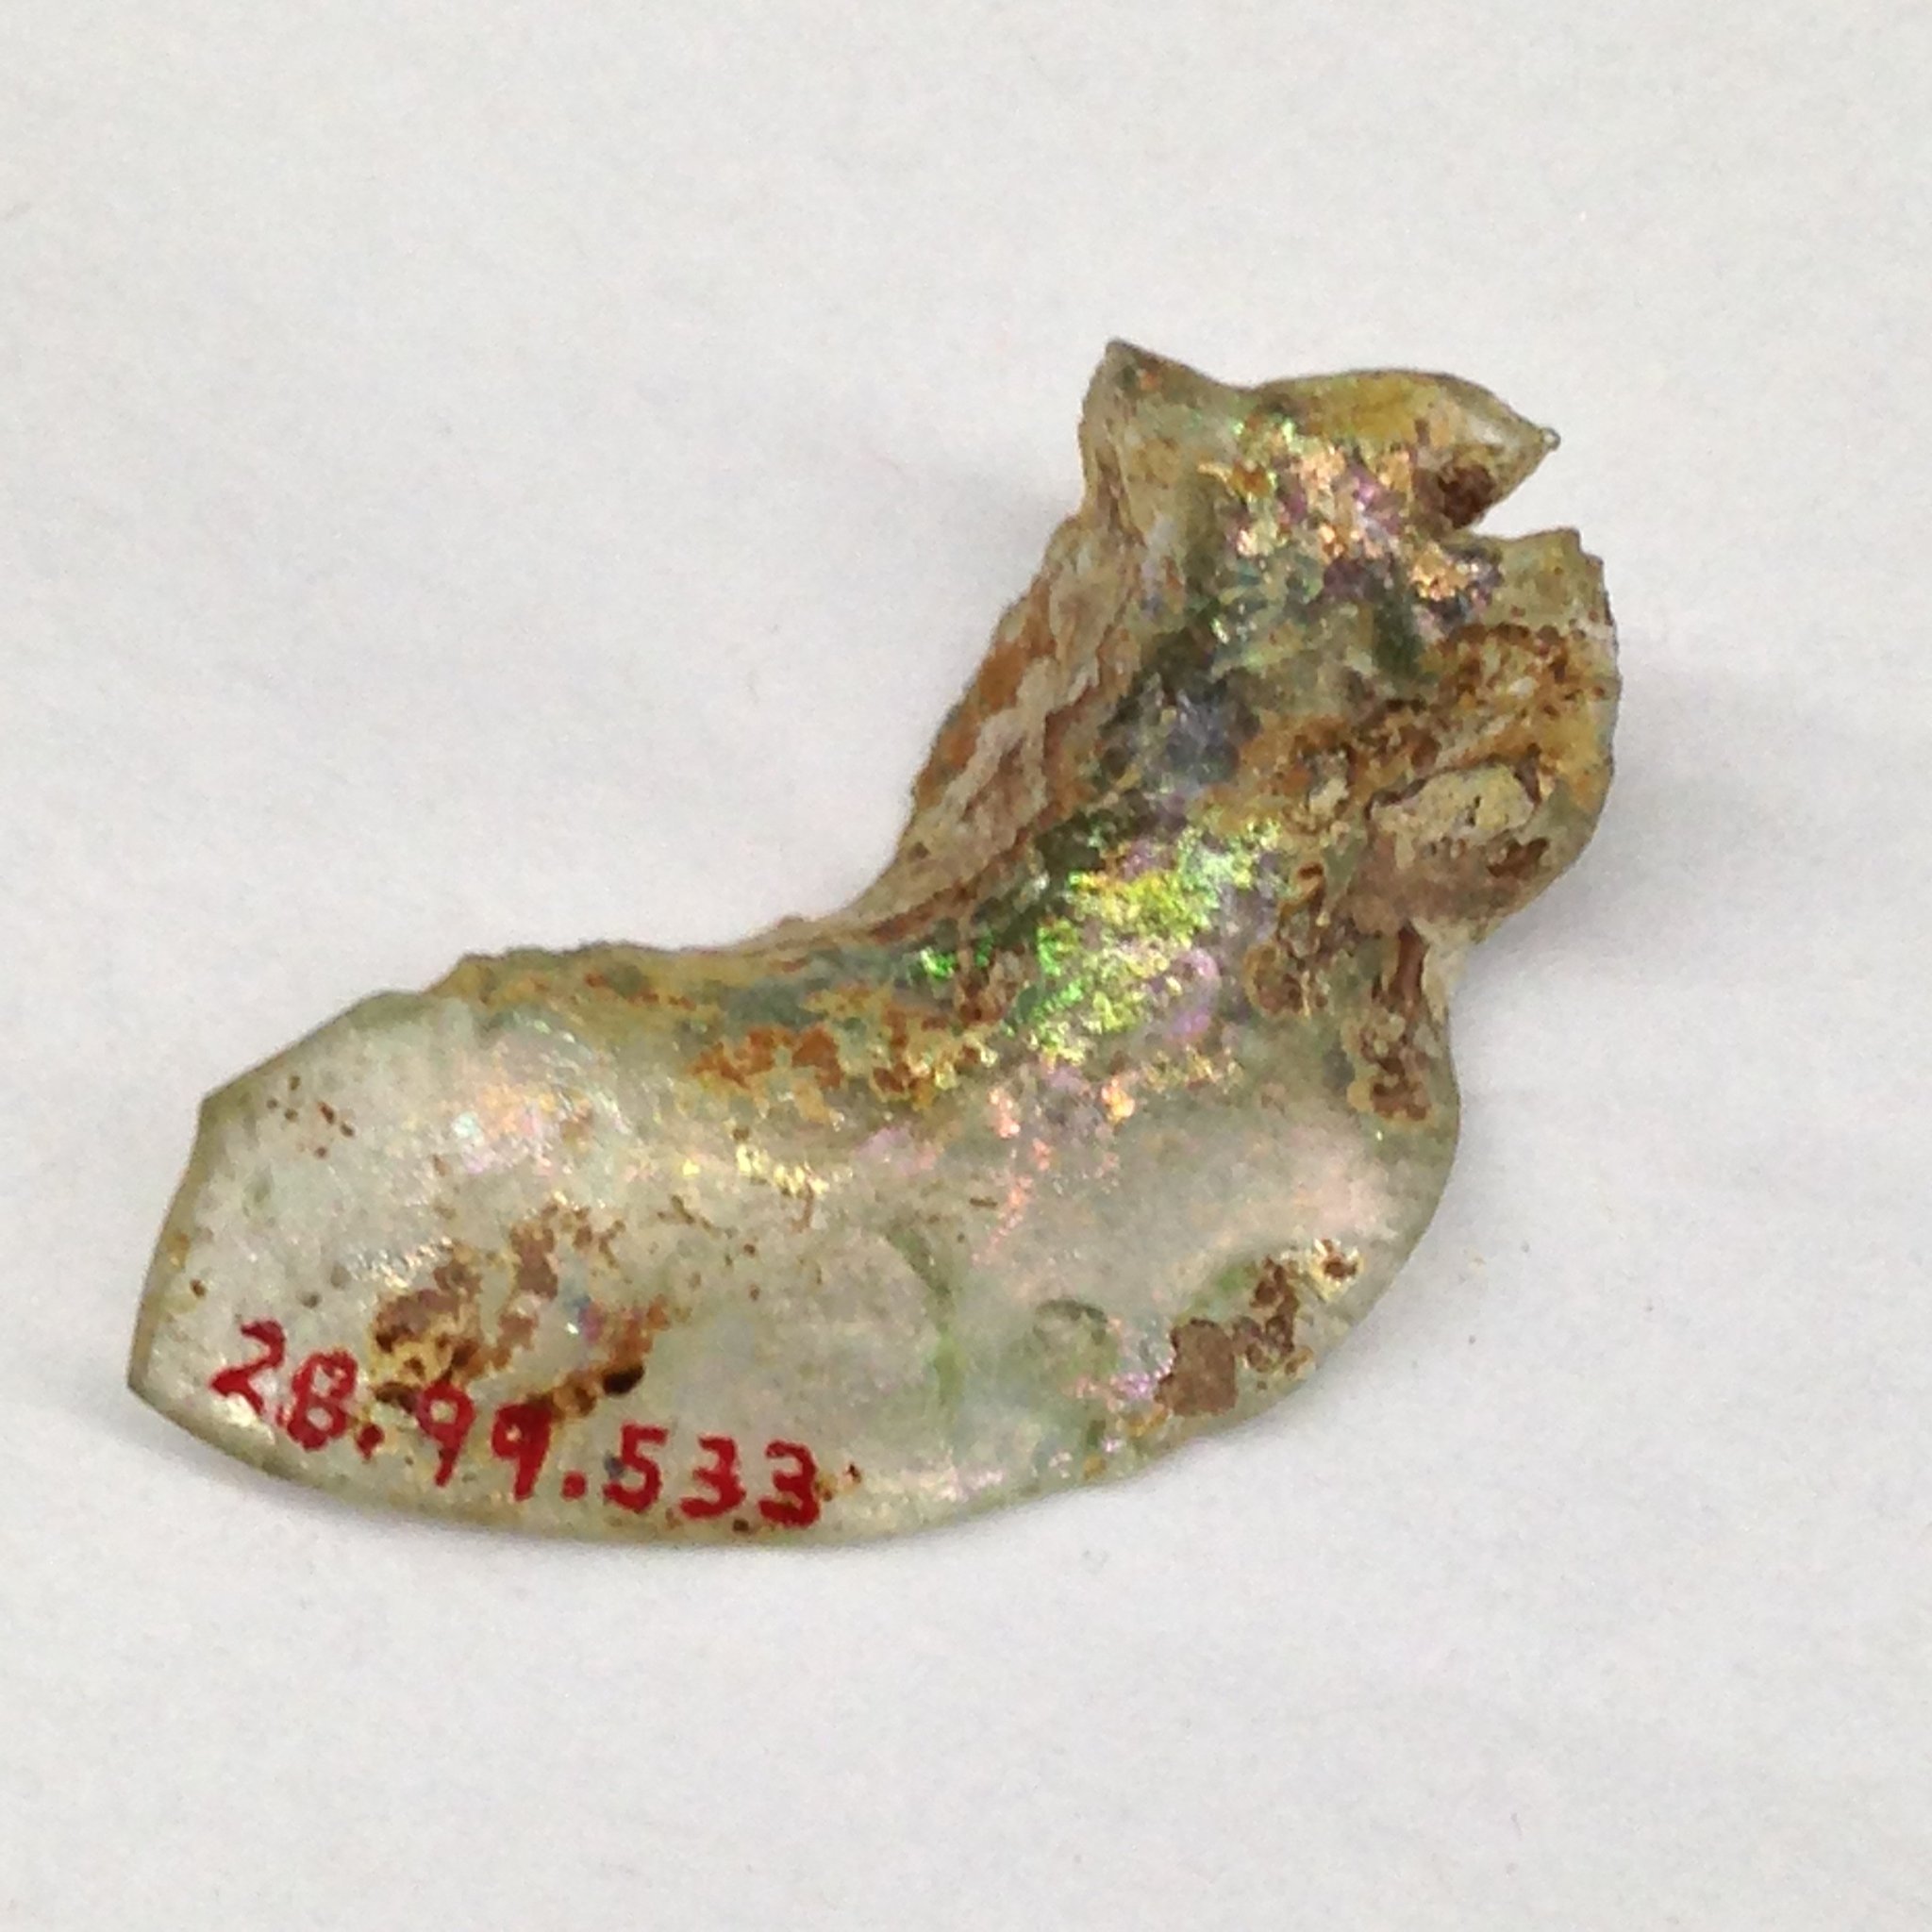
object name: fragment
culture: european or middle eastern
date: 1150-1250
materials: ceramic, glass